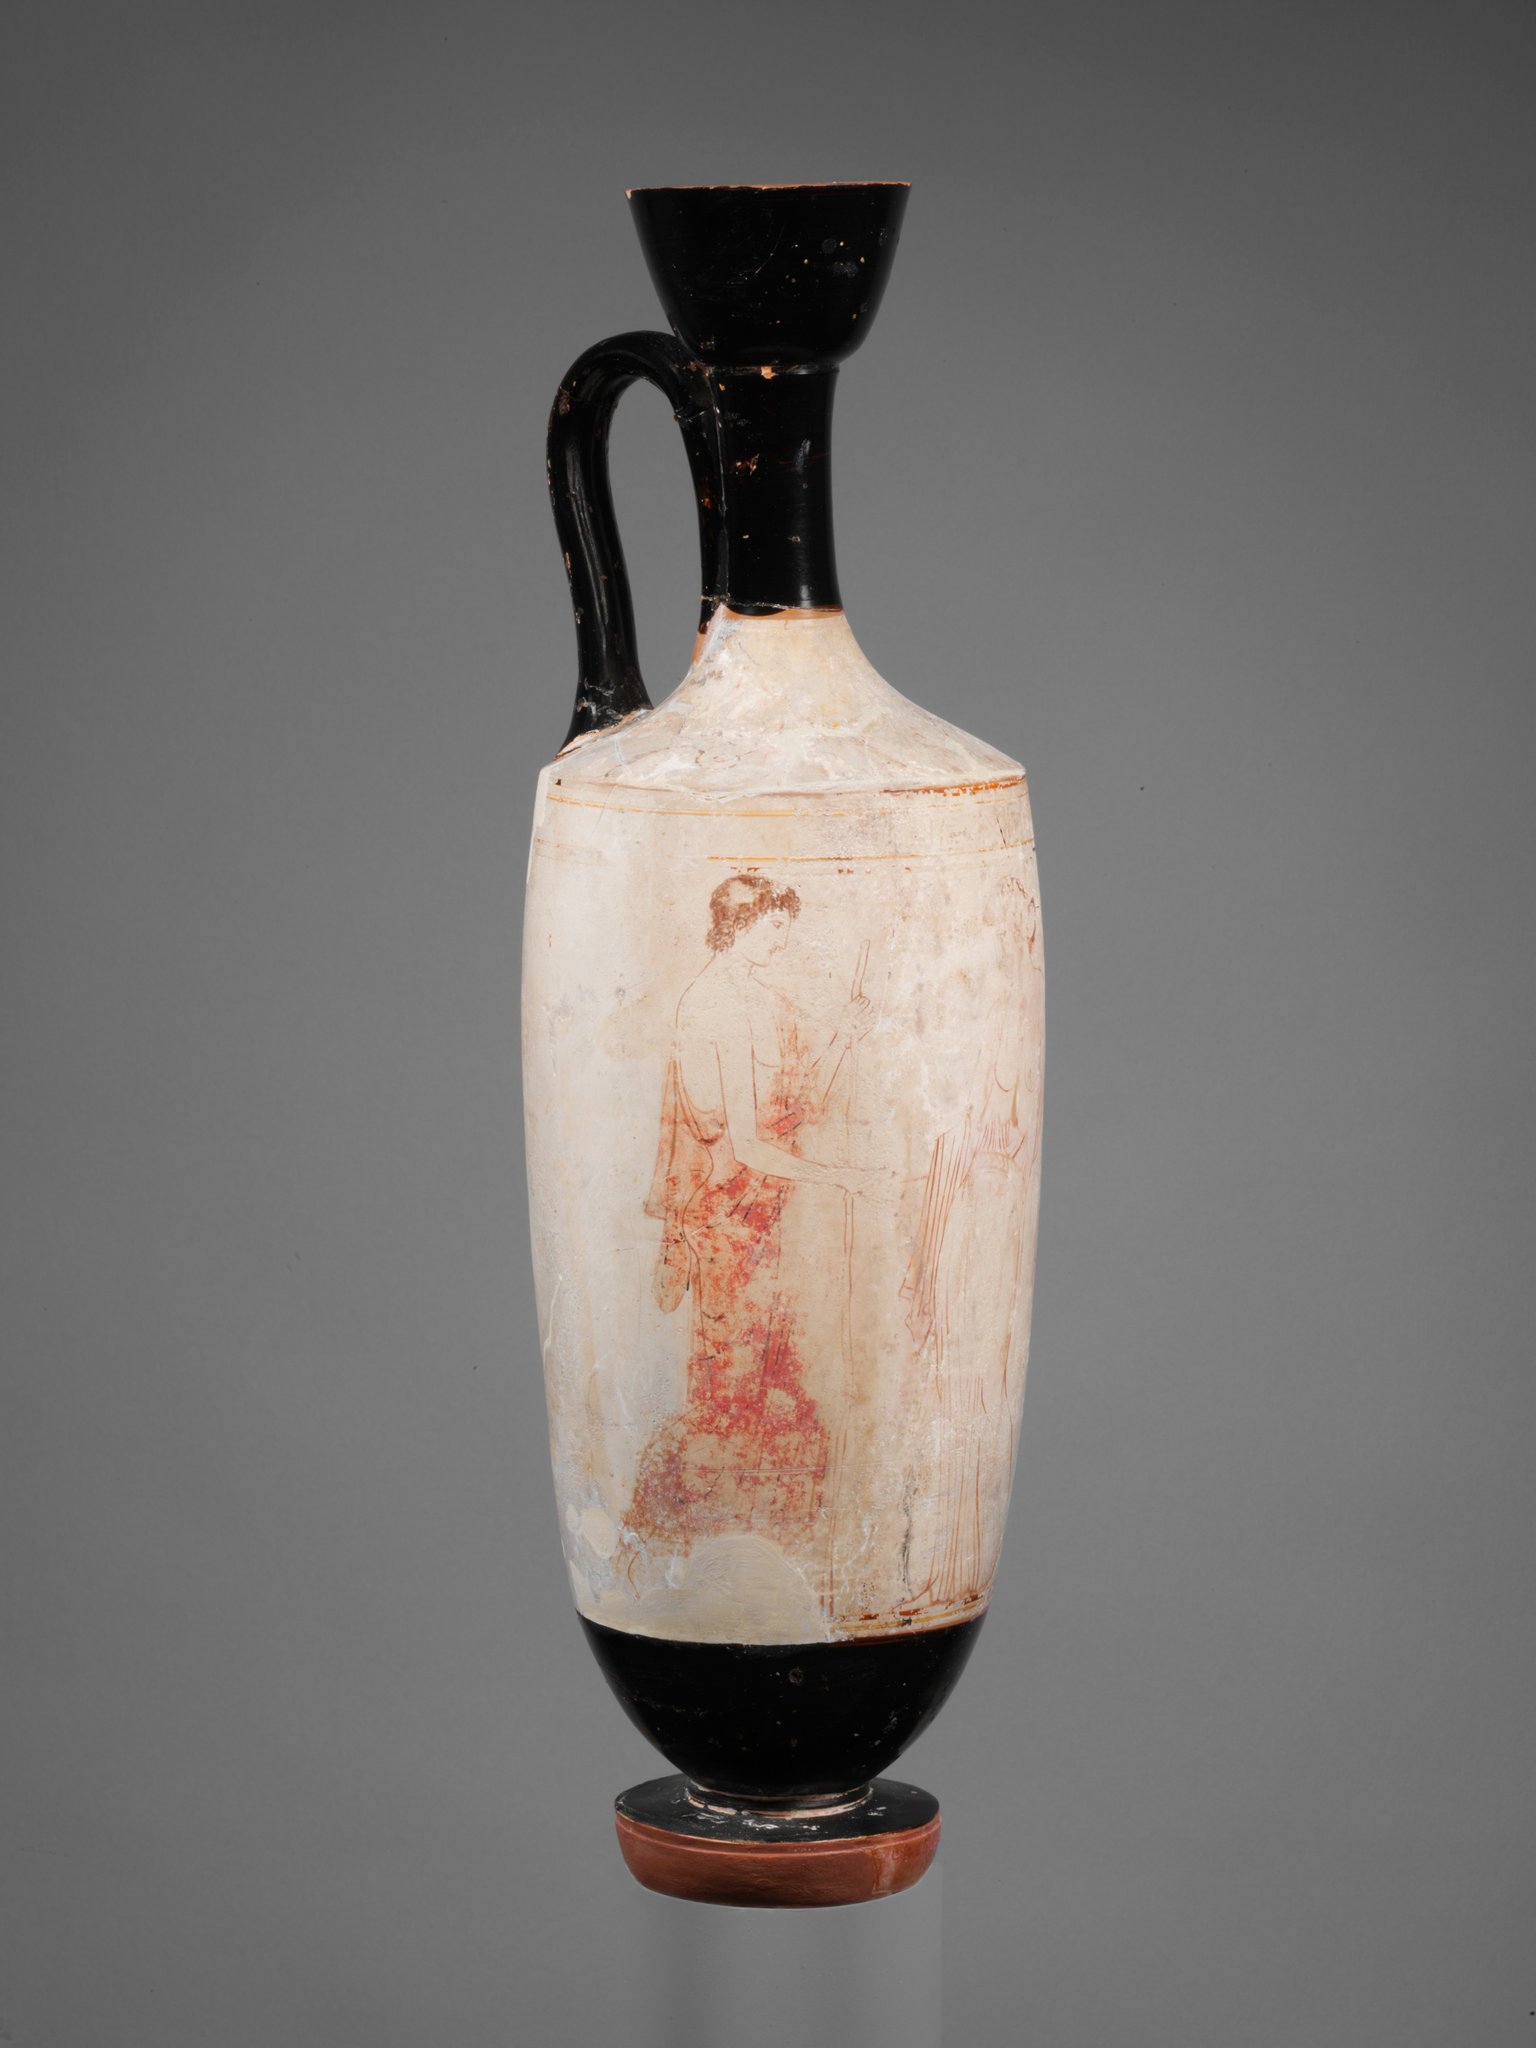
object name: lekythos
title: Terracotta lekythos (oil flask)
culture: greek, attic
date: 420 BCE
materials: terracotta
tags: men,women